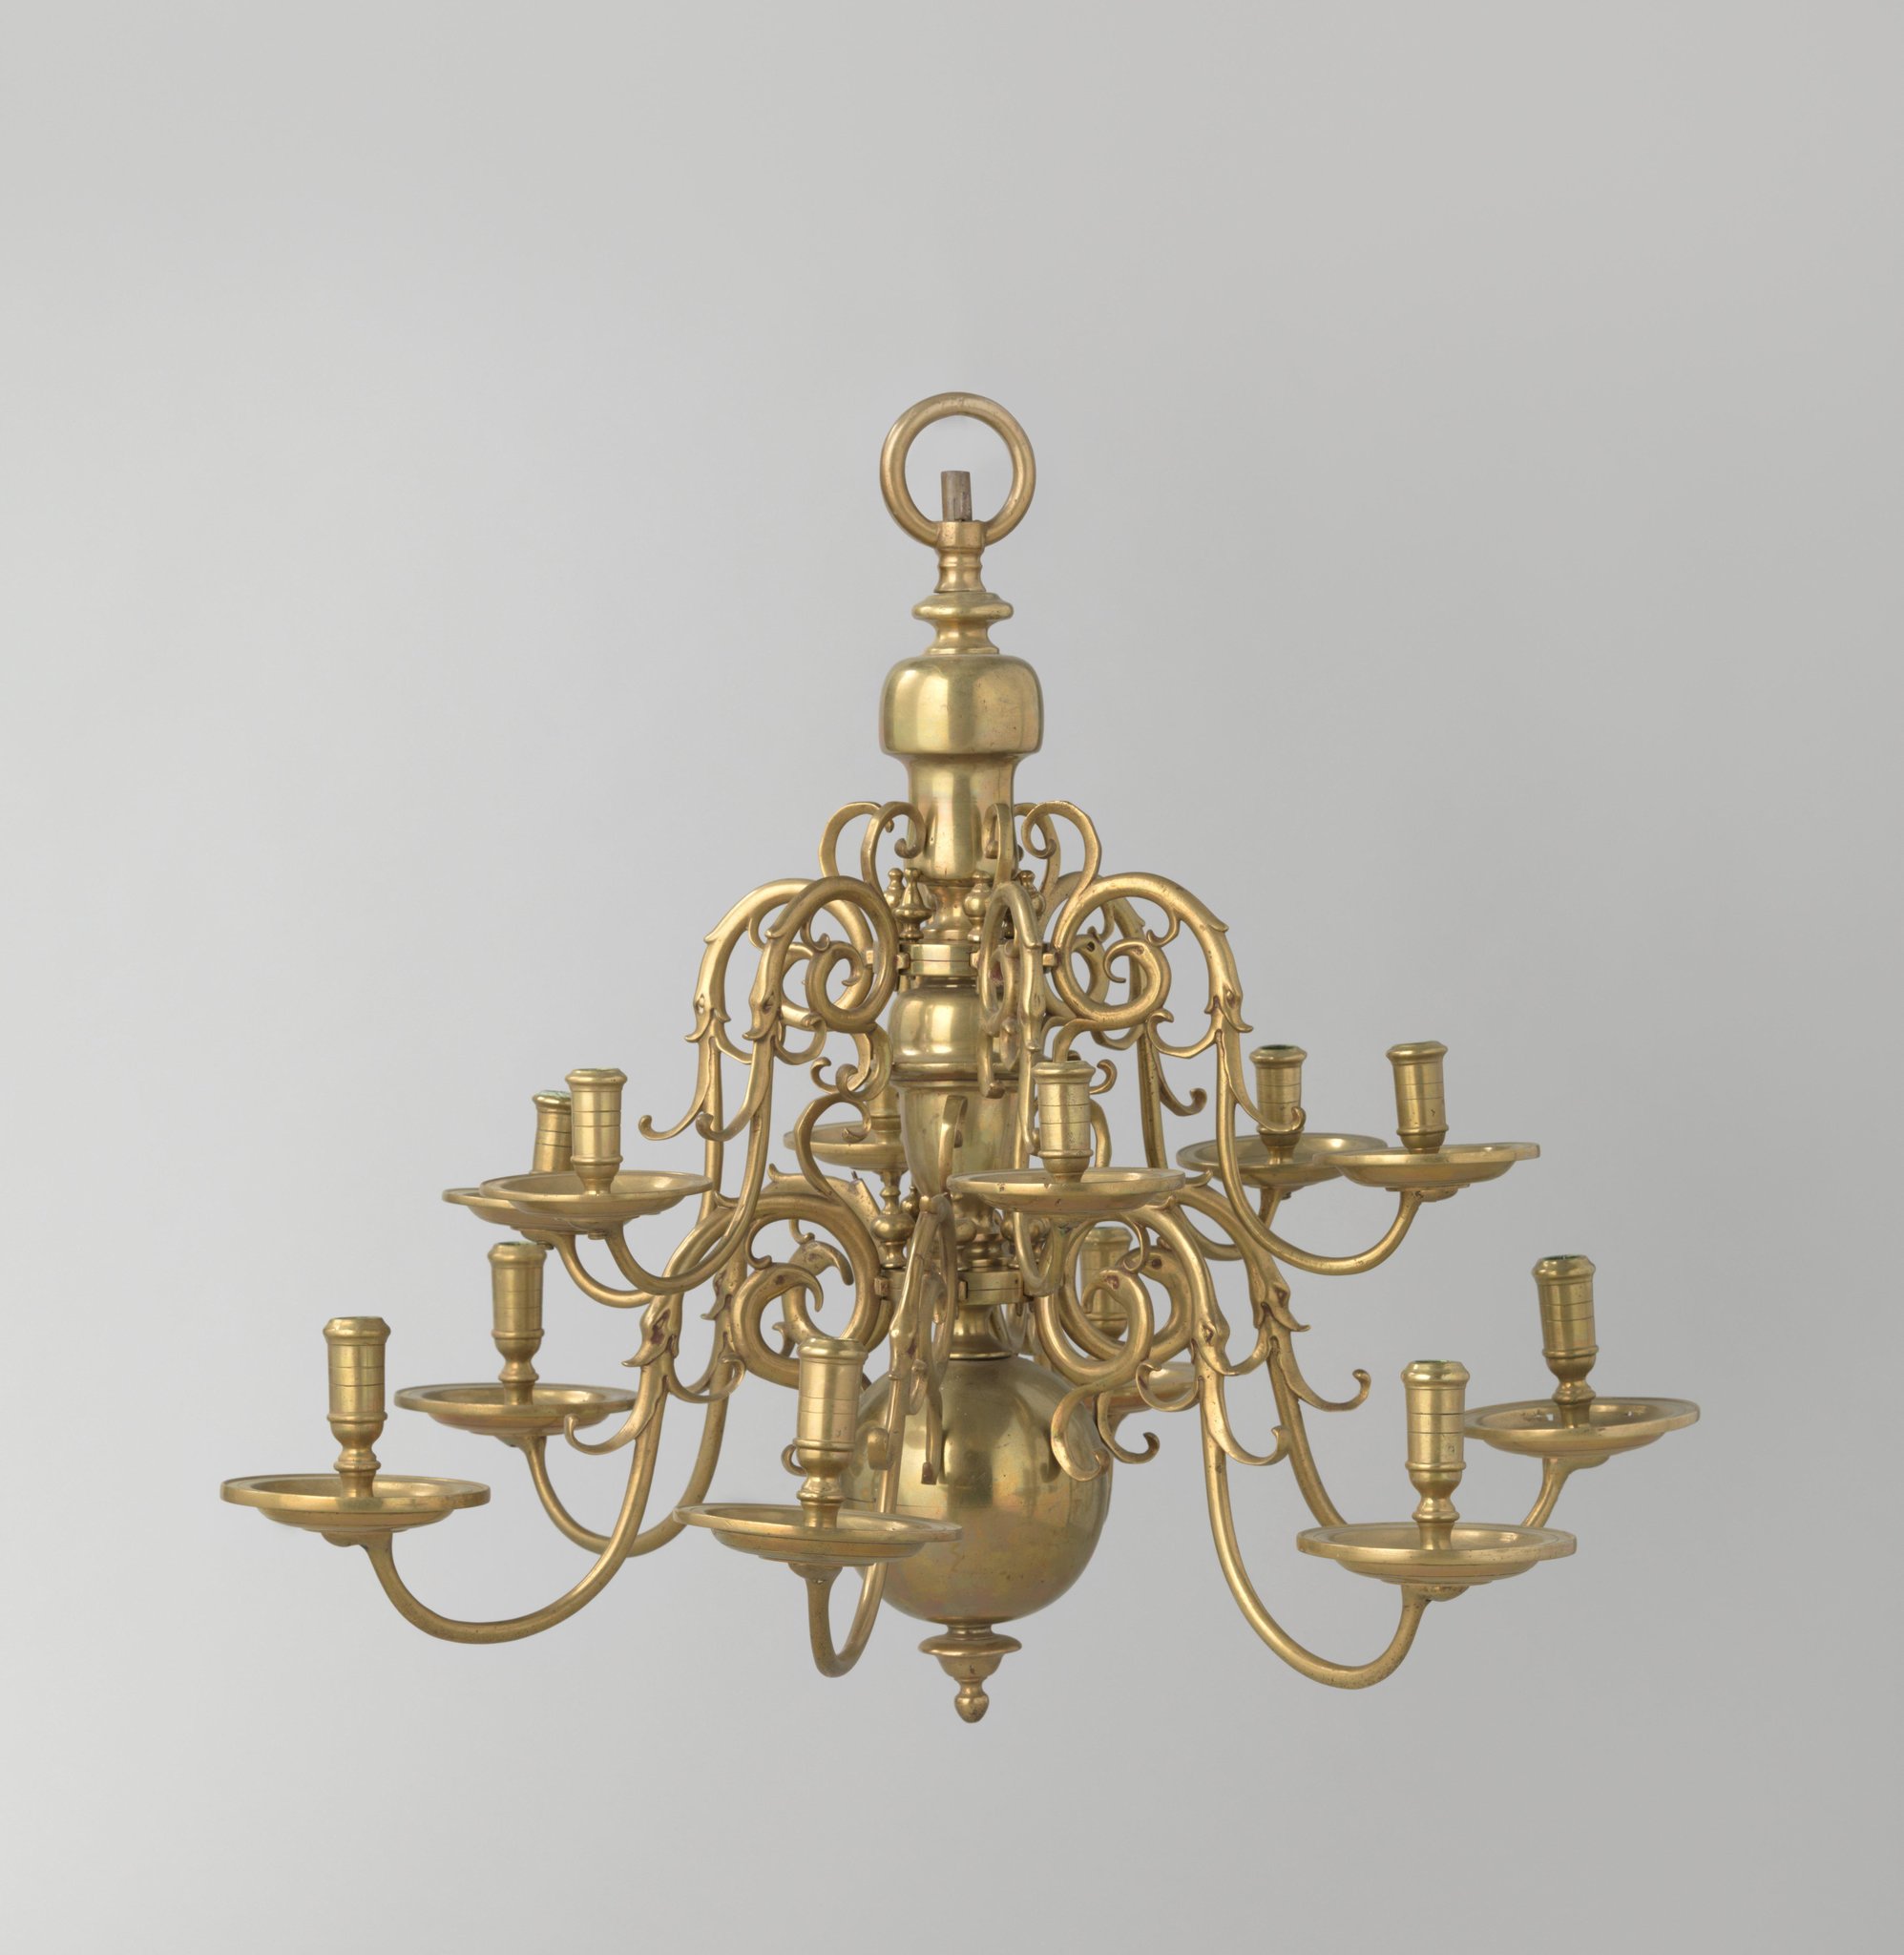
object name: chandelier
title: Arm met kaarsenhouder van kaarsenkroon van twee hoogten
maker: Anonymous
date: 1800-1875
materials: brass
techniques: casting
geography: netherlands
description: Kaarsenarm behorende bij een messing kaarsenkroon van twee hoogten. De S-vormige arm heeft een krul bij de aanzet, halverwege een dolfijnenkop en gaat naar buiten toe over in het platte verdikking met een schroefgat. Daarin is de kaarsenhouder met de vetvanger vastgezet. De vetvanger is aan de onderzijde geribd geprofileerd rond de opening en heeft een naar onder en naar boven toe iets uitstekend randje en is versierd met gegroefde forse ringen. De cylindrische kaarsenhouder heeft een geprofileerde en een weinig uitstekende rand, twee gegroefde ringen, een rib en een geprofileerd holrond onderstuk, dat overgaat in een uitsteeksel met een schroefdraad met een centergat. Dit is de tweede arm van de onderste standring, genummerd met 2 ronde punten.